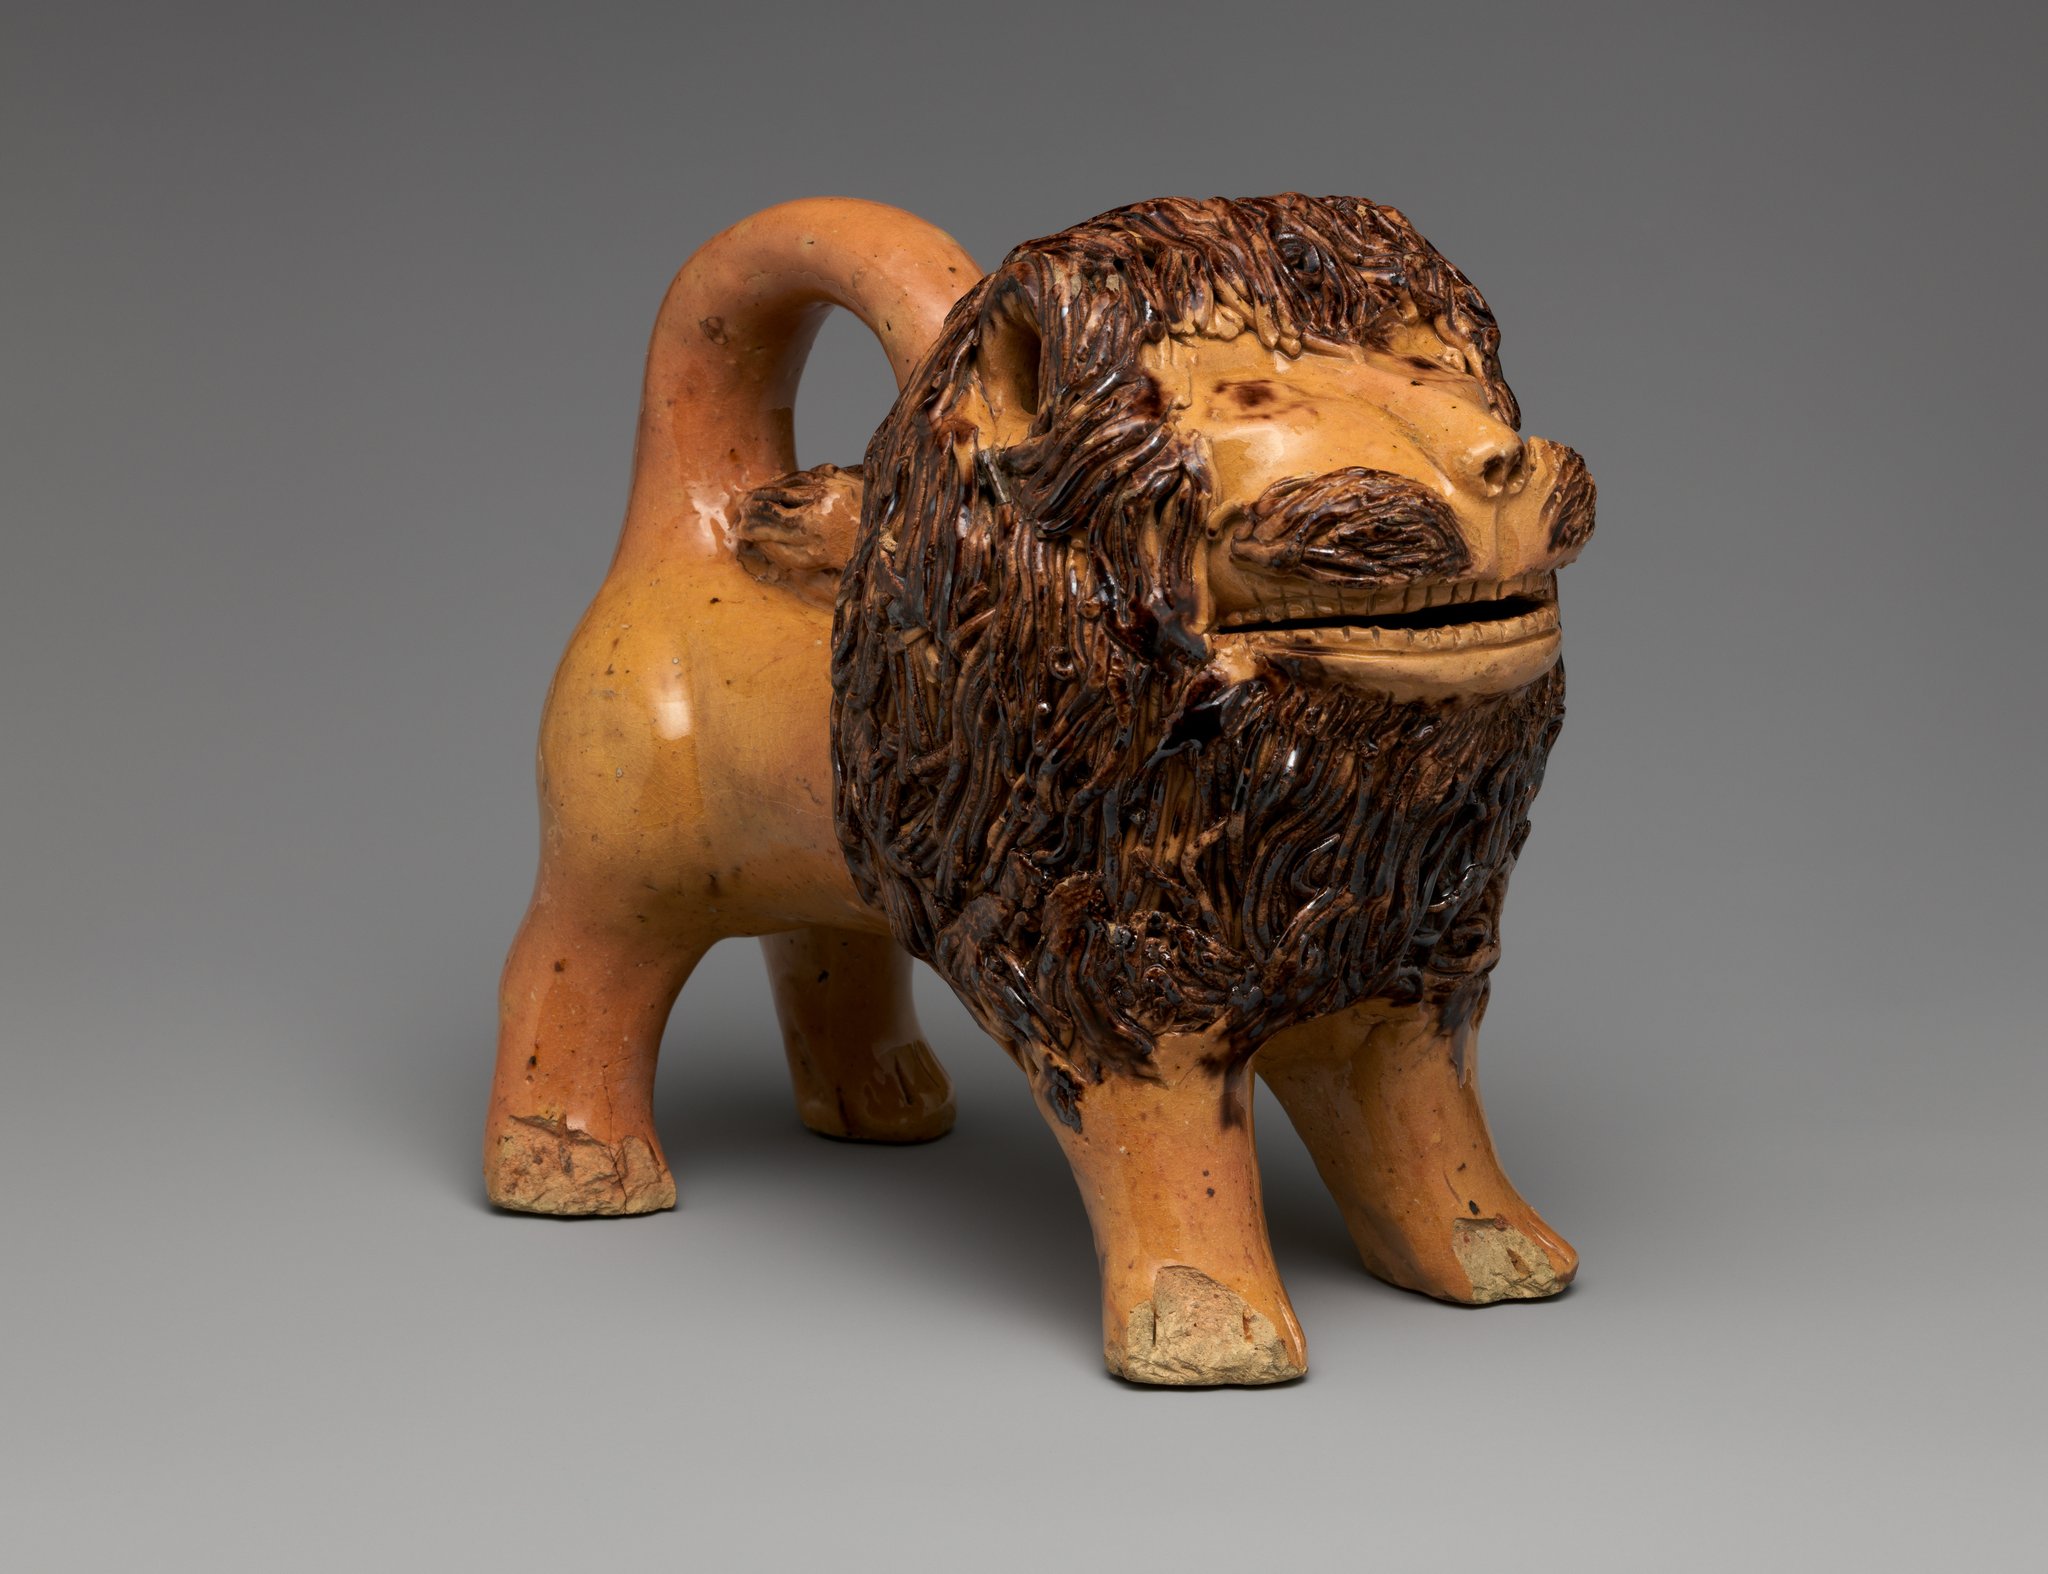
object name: figure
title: Figure of a Lion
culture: american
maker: john bell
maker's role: artist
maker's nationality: american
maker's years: 1800-1880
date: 1845-1855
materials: earthenware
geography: united states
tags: lions